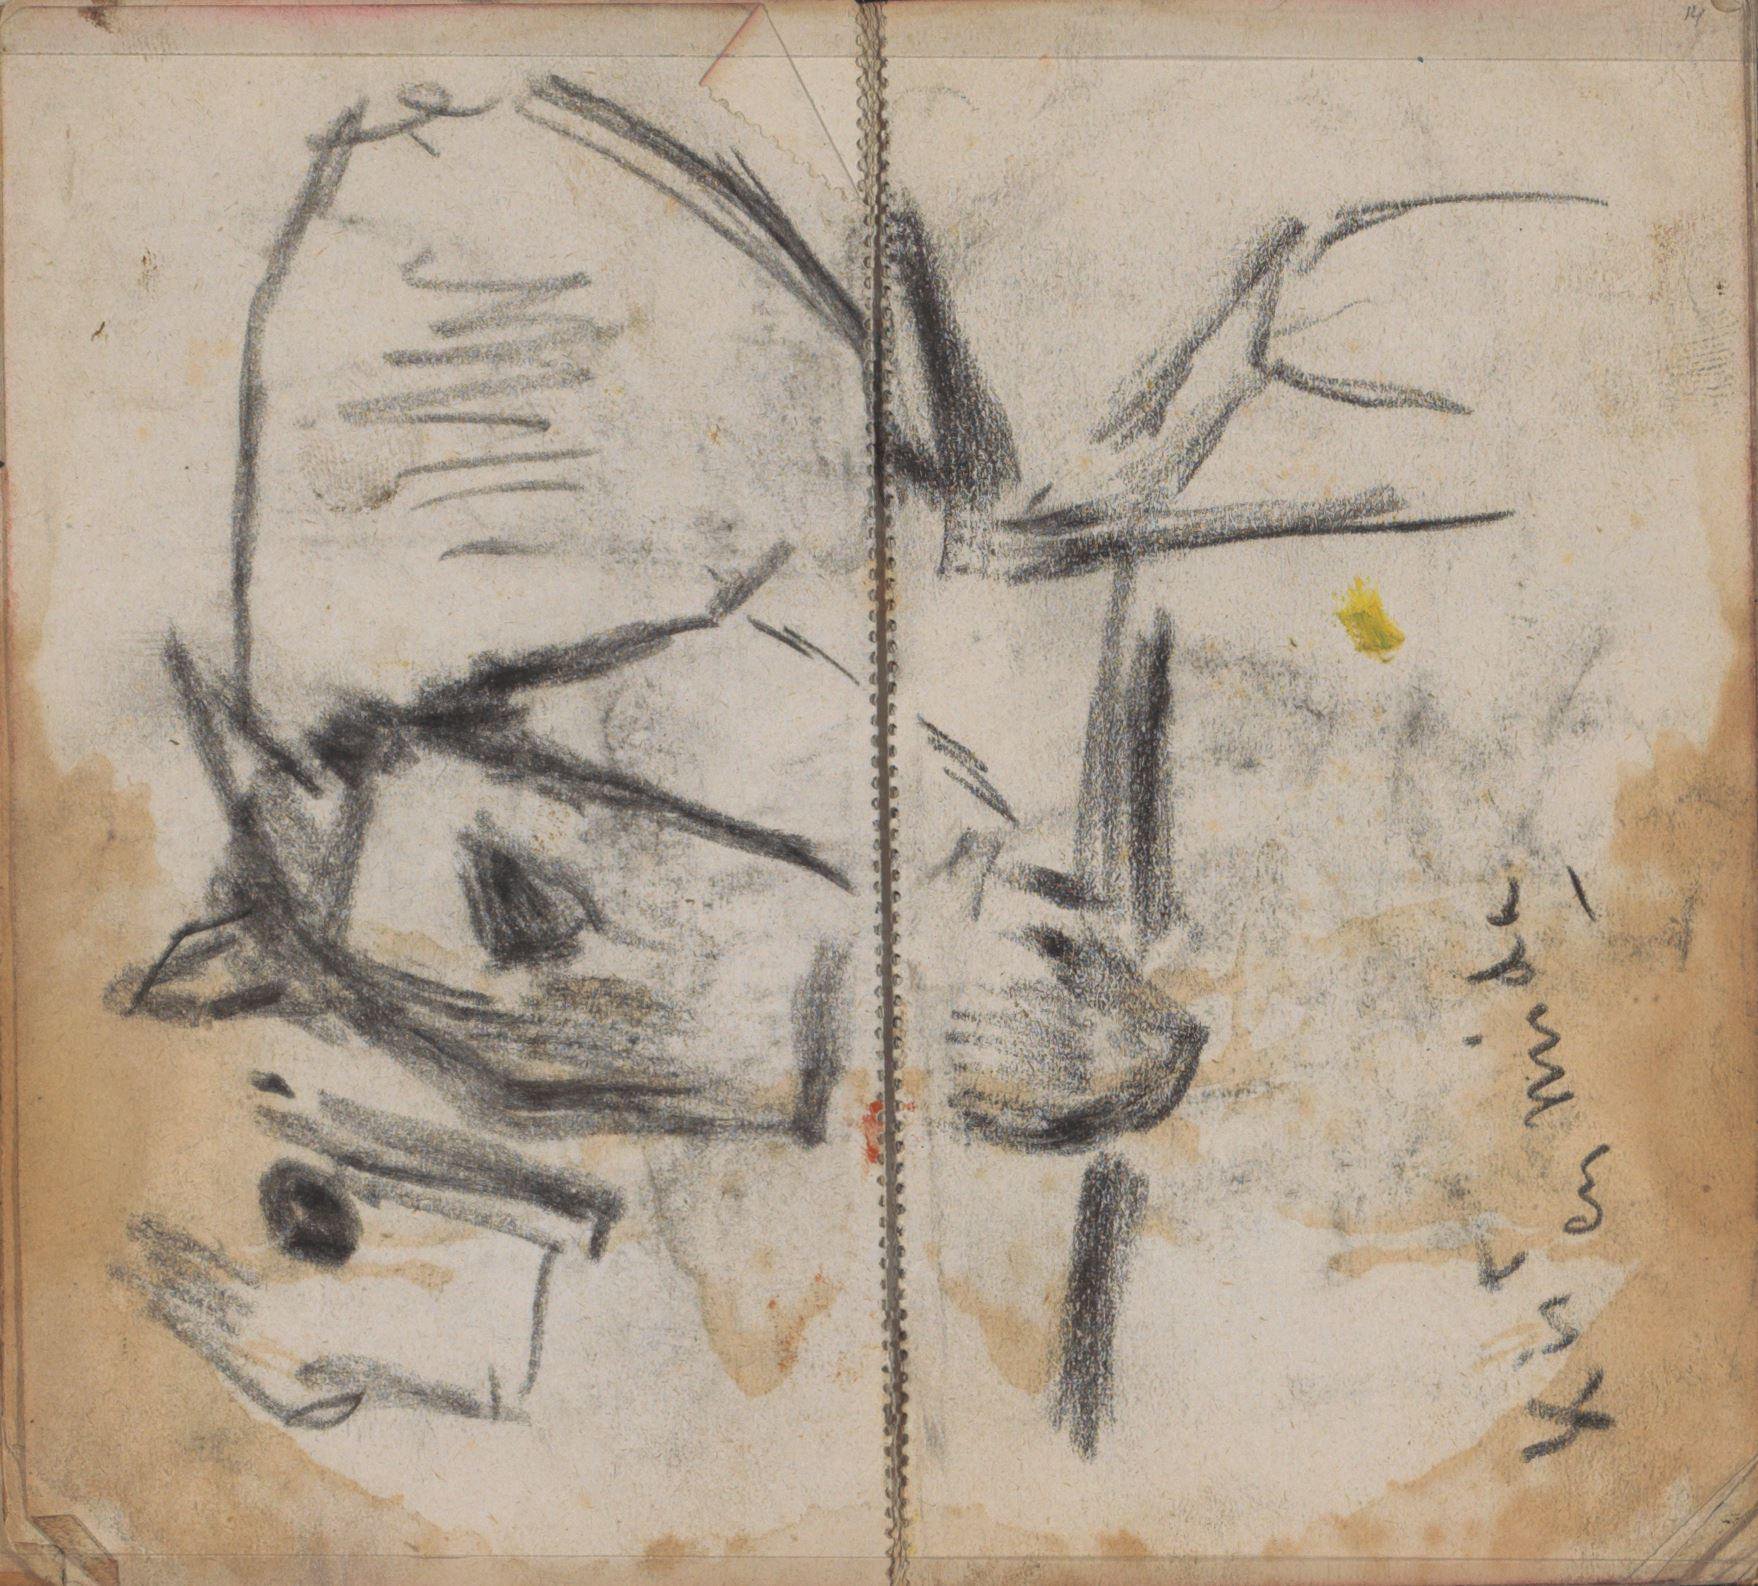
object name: sketchbook leaf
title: Twee paarden met hoofdstel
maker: george hendrik breitner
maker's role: draughtsman, painter, print maker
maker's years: 1857-1923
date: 1893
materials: chalk, paper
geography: amsterdam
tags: horse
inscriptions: annotation: ‘Kist/ en Mida’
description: Twee paarden met hoofdstel. Pagina 13 en pagina 14 uit een schetsboek met 22 bladen vervaardigd te Amsterdam.